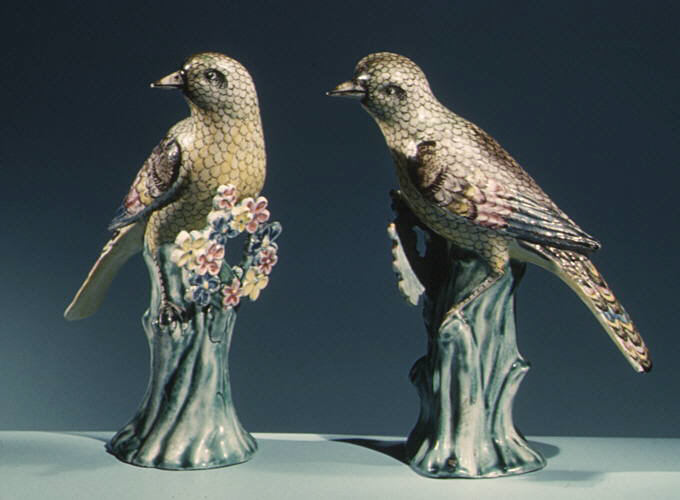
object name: figure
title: Pair of birds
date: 1750-1760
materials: stoneware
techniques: salt glaze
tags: birds,flowers